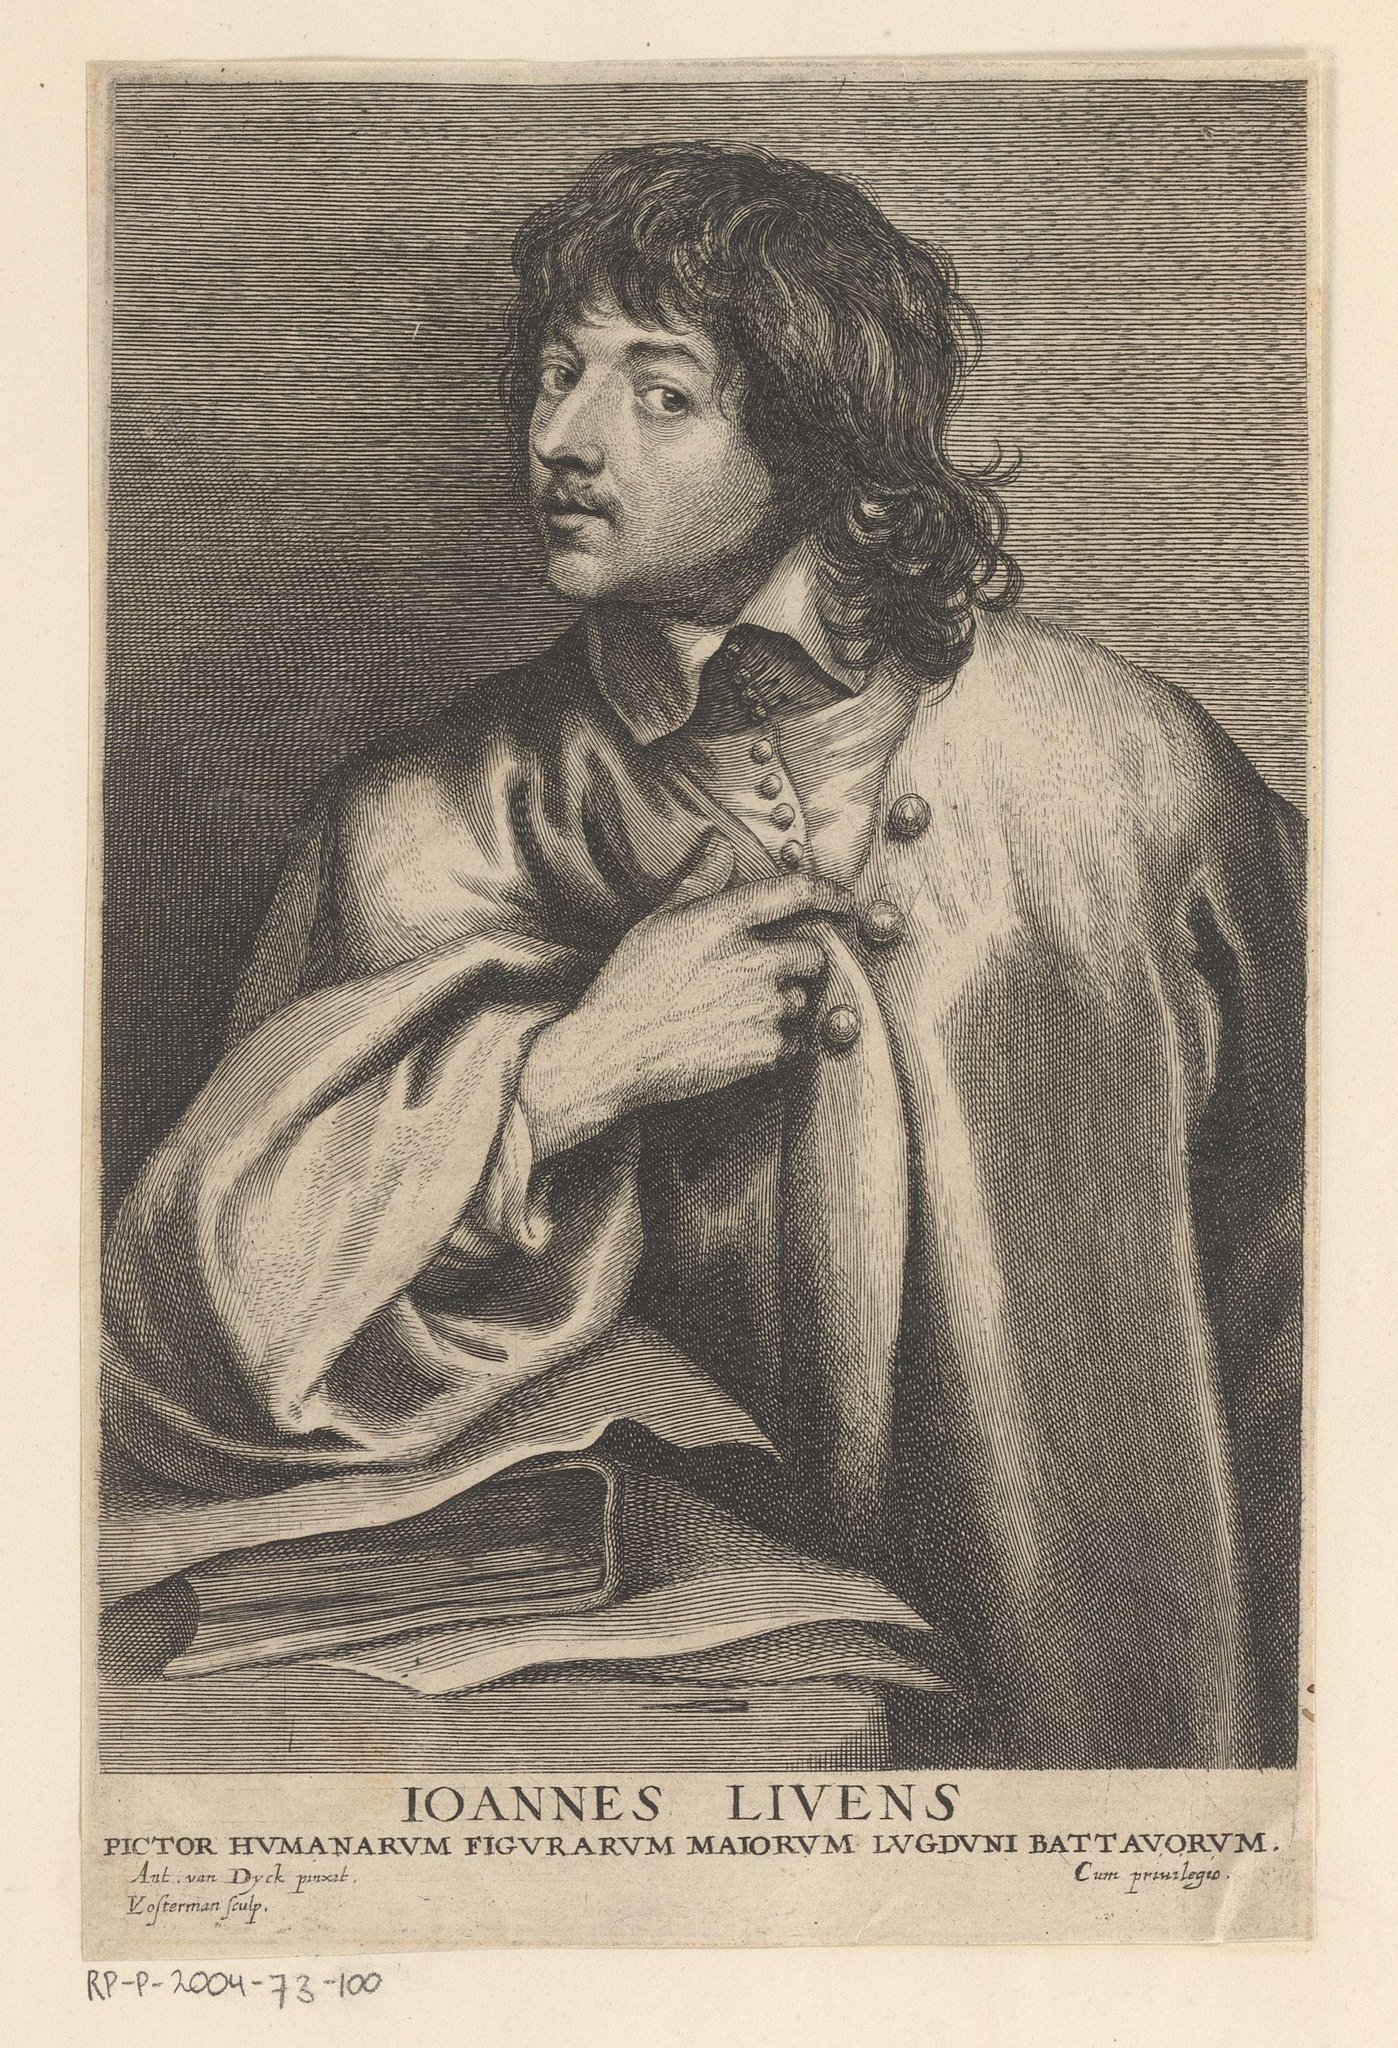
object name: album leaf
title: Portret van Jan Lievens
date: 1645-1646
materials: paper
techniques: engraving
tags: leiden, amsterdam, painter, print maker, draughtsman, jan lievens, historical persons, portrait, self-portrait of painter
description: Prent uit: Iconographie ou Vies des Hommes Illustres du XVII. Siecle (...). 2 dln. Amsterdam: Johann Caspar Arkstee, Leipzig: Henricus Merkus, 1759, dl. 1, p. 90. Prent is ontworpen voor de serie getiteld 'Iconographie' samengesteld door Anthony van Dyck en uitgegeven in 1645-1646. De samensteller heeft deze prent in het album geplakt als illustratie bij: Pilkington, Matthew en Johann Heinrich Füssli. A dictionary of painters, from the revival of the art to the present period. 4 dln. Londen: John Crowder, 1805, dl. 2, p. 296.